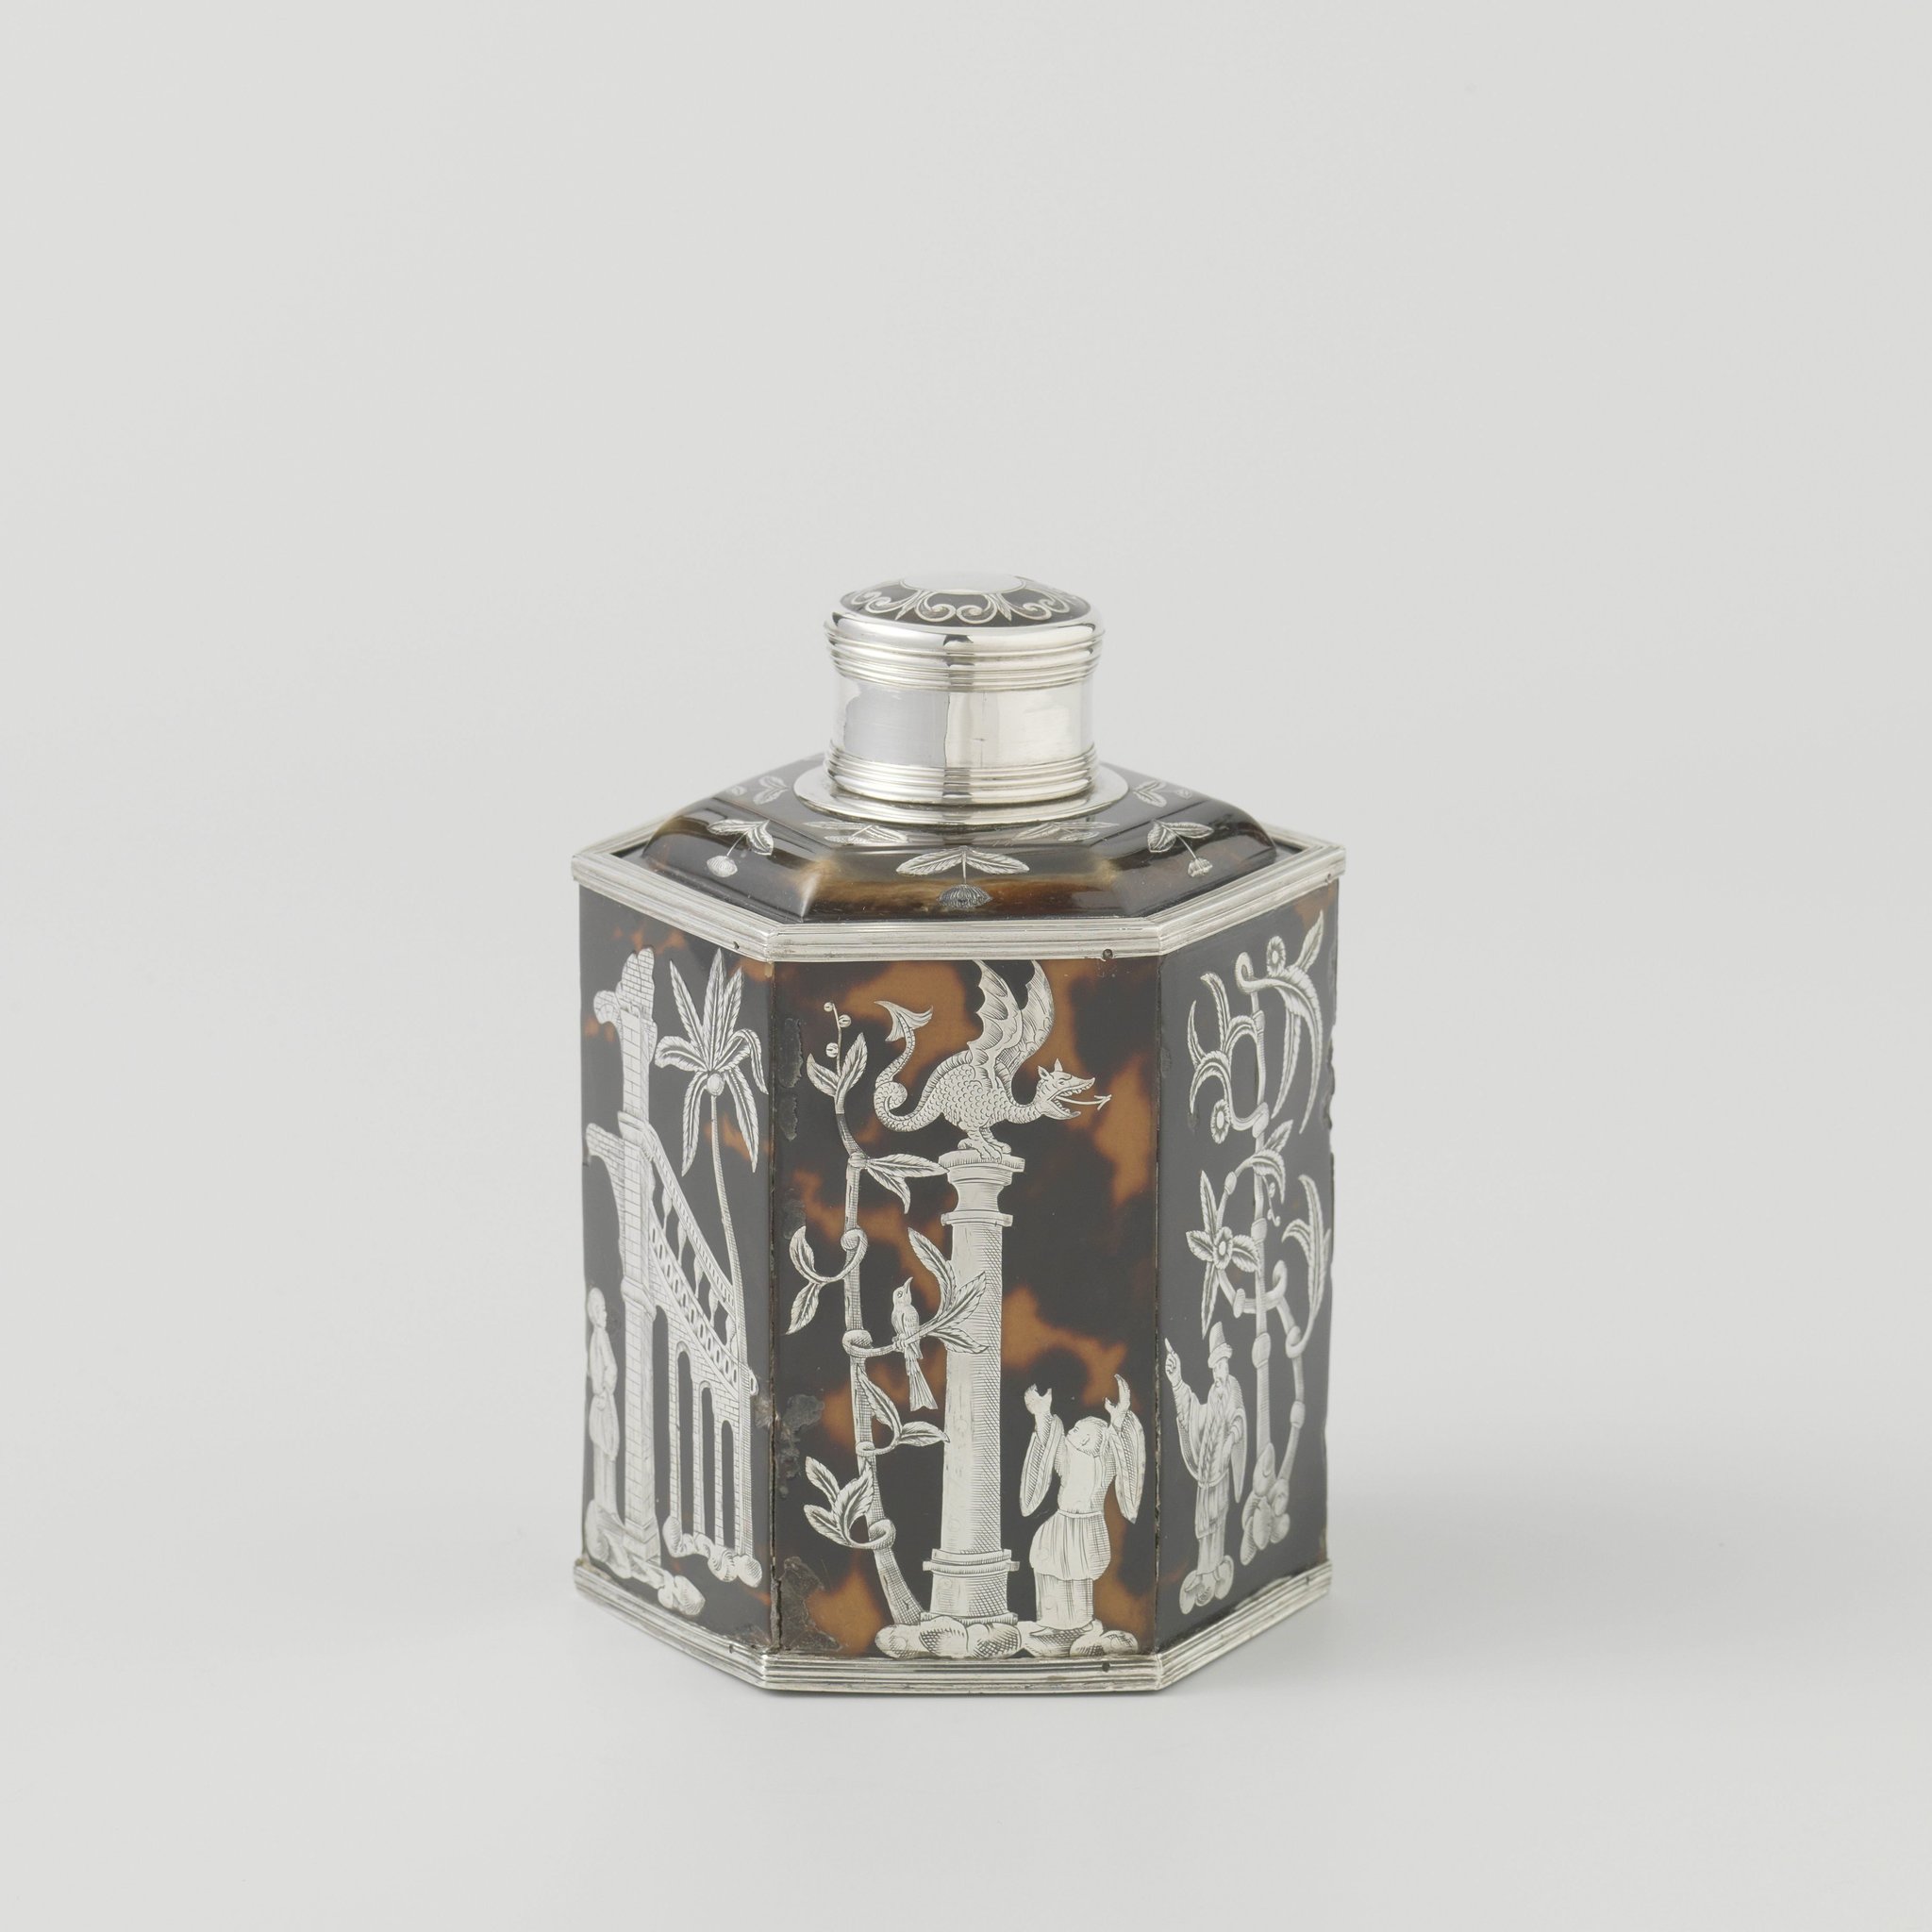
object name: tea caddy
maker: eusebius willem voet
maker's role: silversmith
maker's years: 1660-1719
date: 1700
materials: silver, shell, wood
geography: zwolle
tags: chinese (+ other cultural aspects)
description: Even though more and more people began drinking tea at the end of the century, it was still considered a luxury. Hence, the exotic and costly tortoiseshell – against which the silver stands out handsomely – used for this caddy was a fitting choice. The silver inlay decoration is freely conceived and refers only distantly to Asia. Eusebius Voet, or his brother Hendrik, was probably responsible for this design.